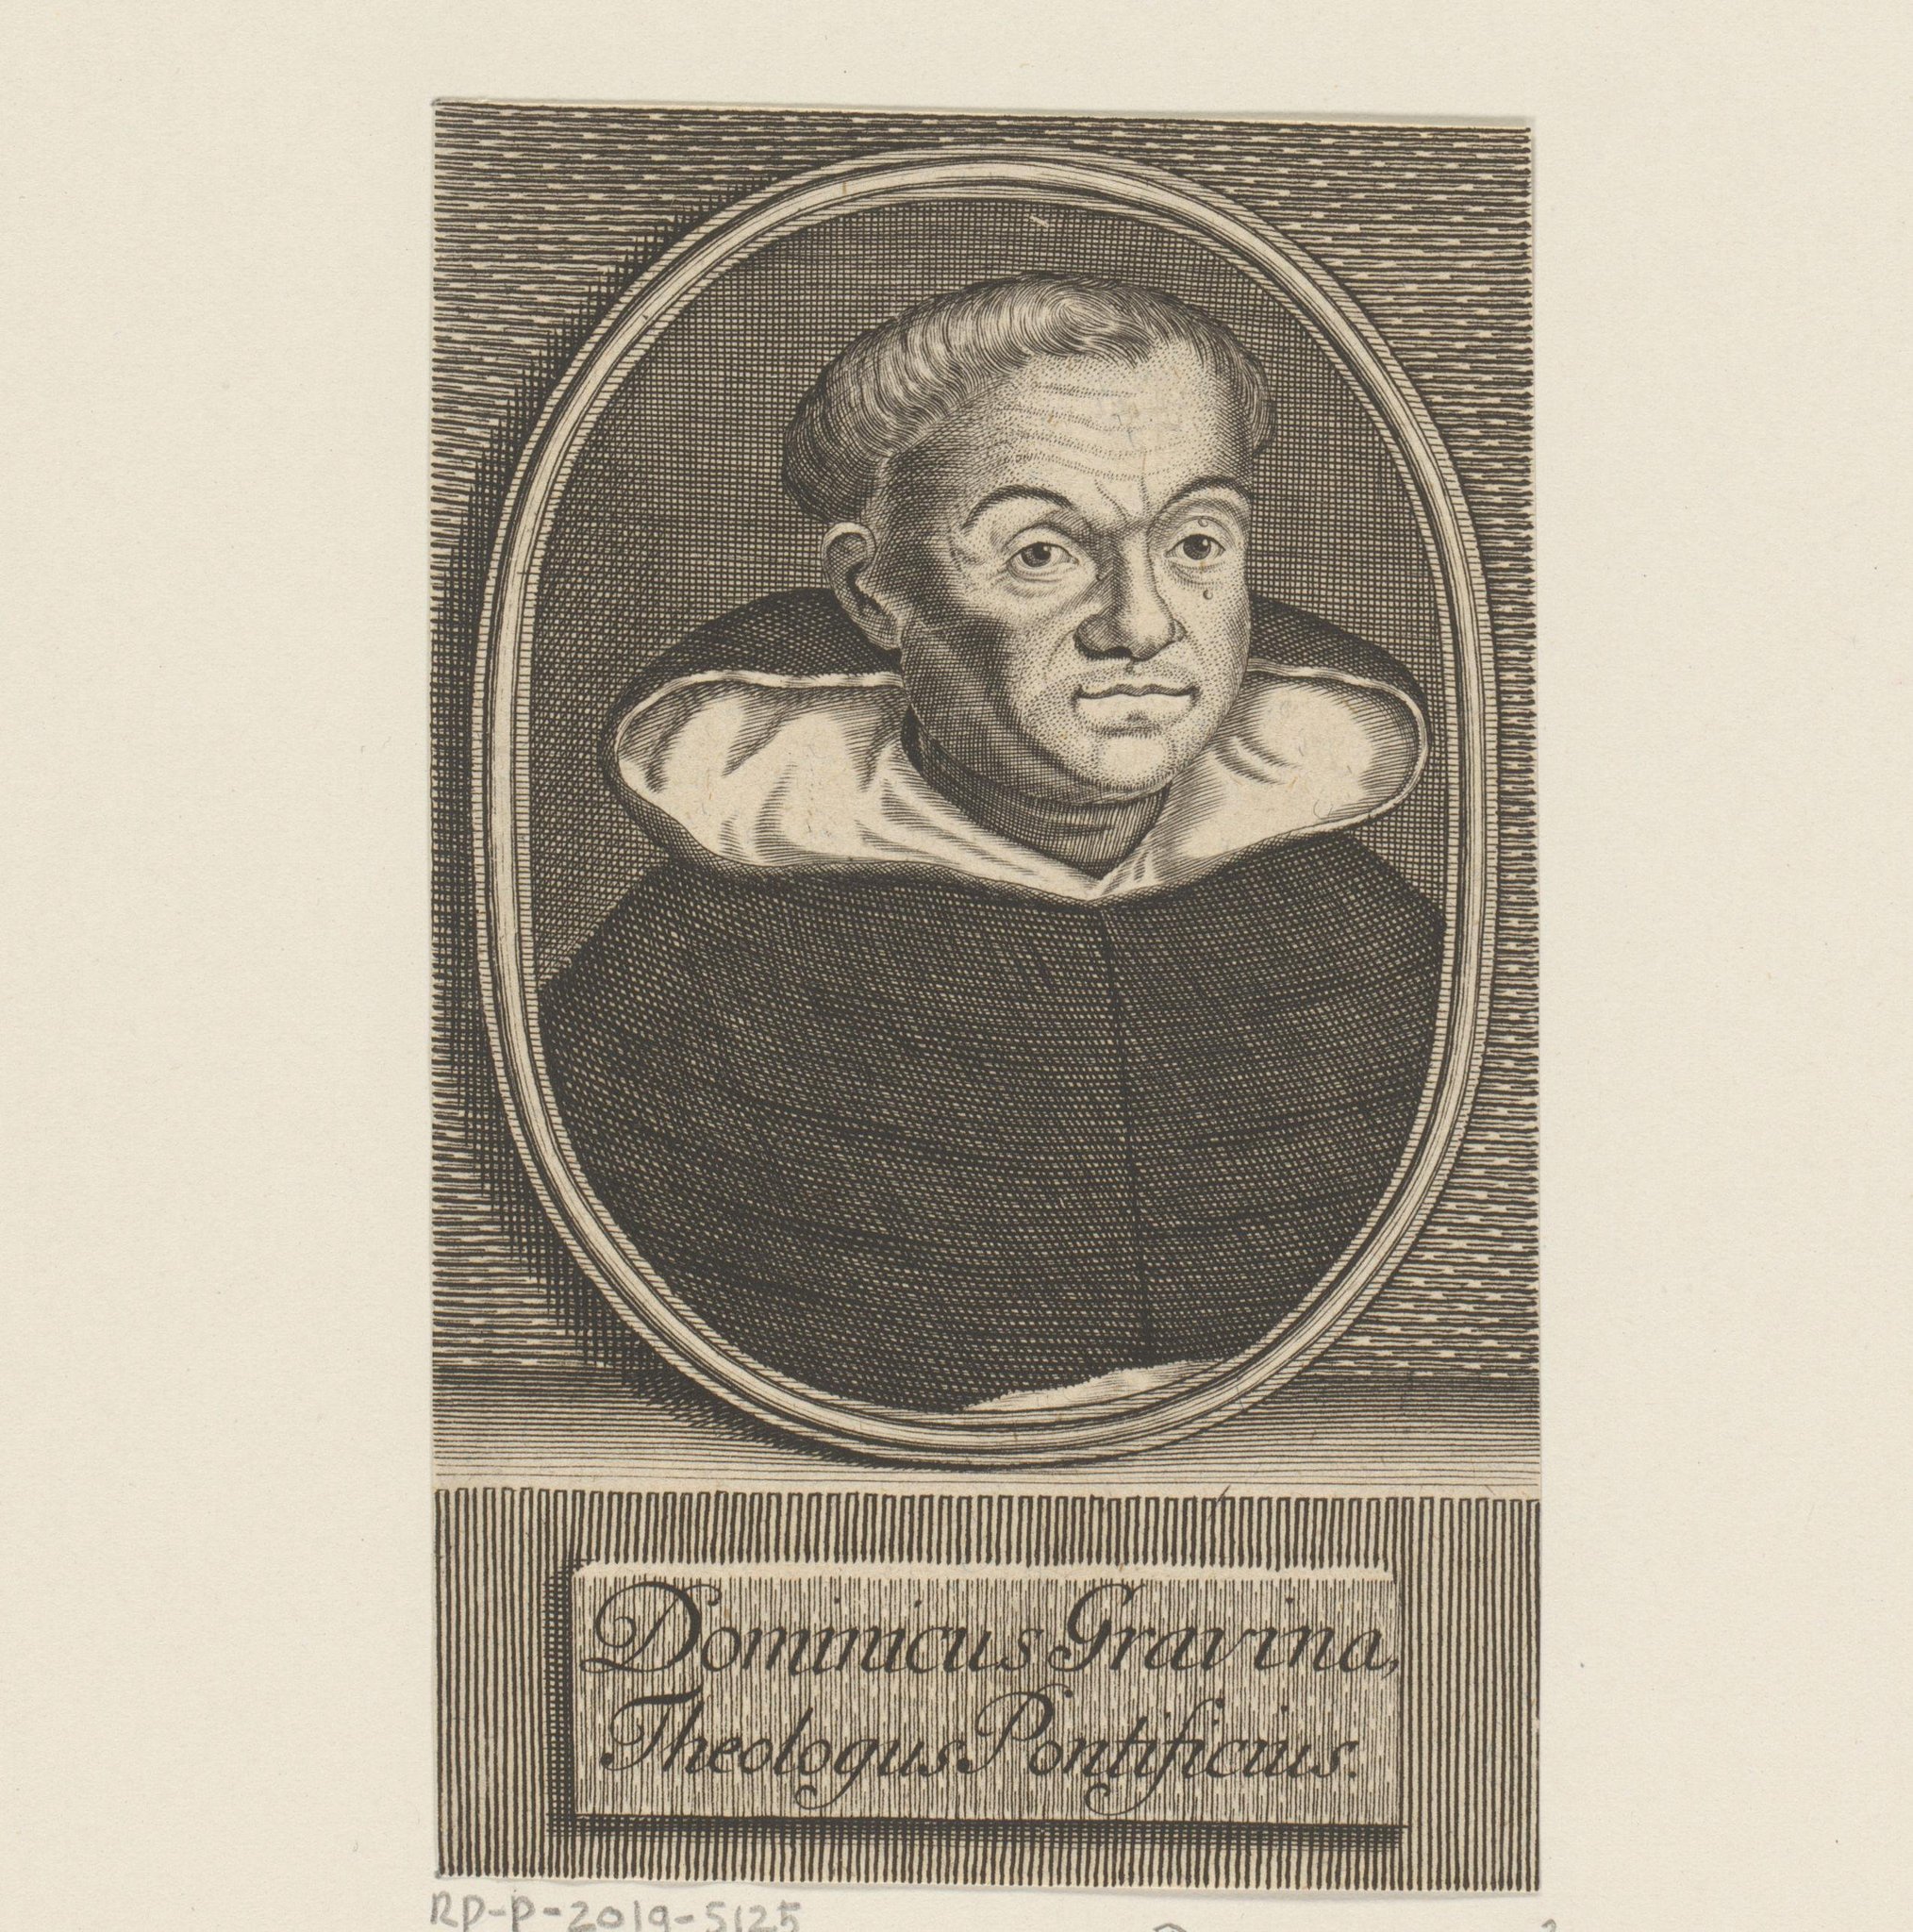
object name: book illustration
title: Domenicus Gravina, Theologus Pontificus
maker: Anonymous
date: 1737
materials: paper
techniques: engraving, letterpress printing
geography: leipzig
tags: rome, theologian, historical persons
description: Prent uit: Fortgesetzte Sammlung von Alten und Neuen Theologischen Sachen (...) Sechster Beytrag auf das Jahr 1737. Leipzig: Johann Friedrich Brauns sel. Erben, 1737.